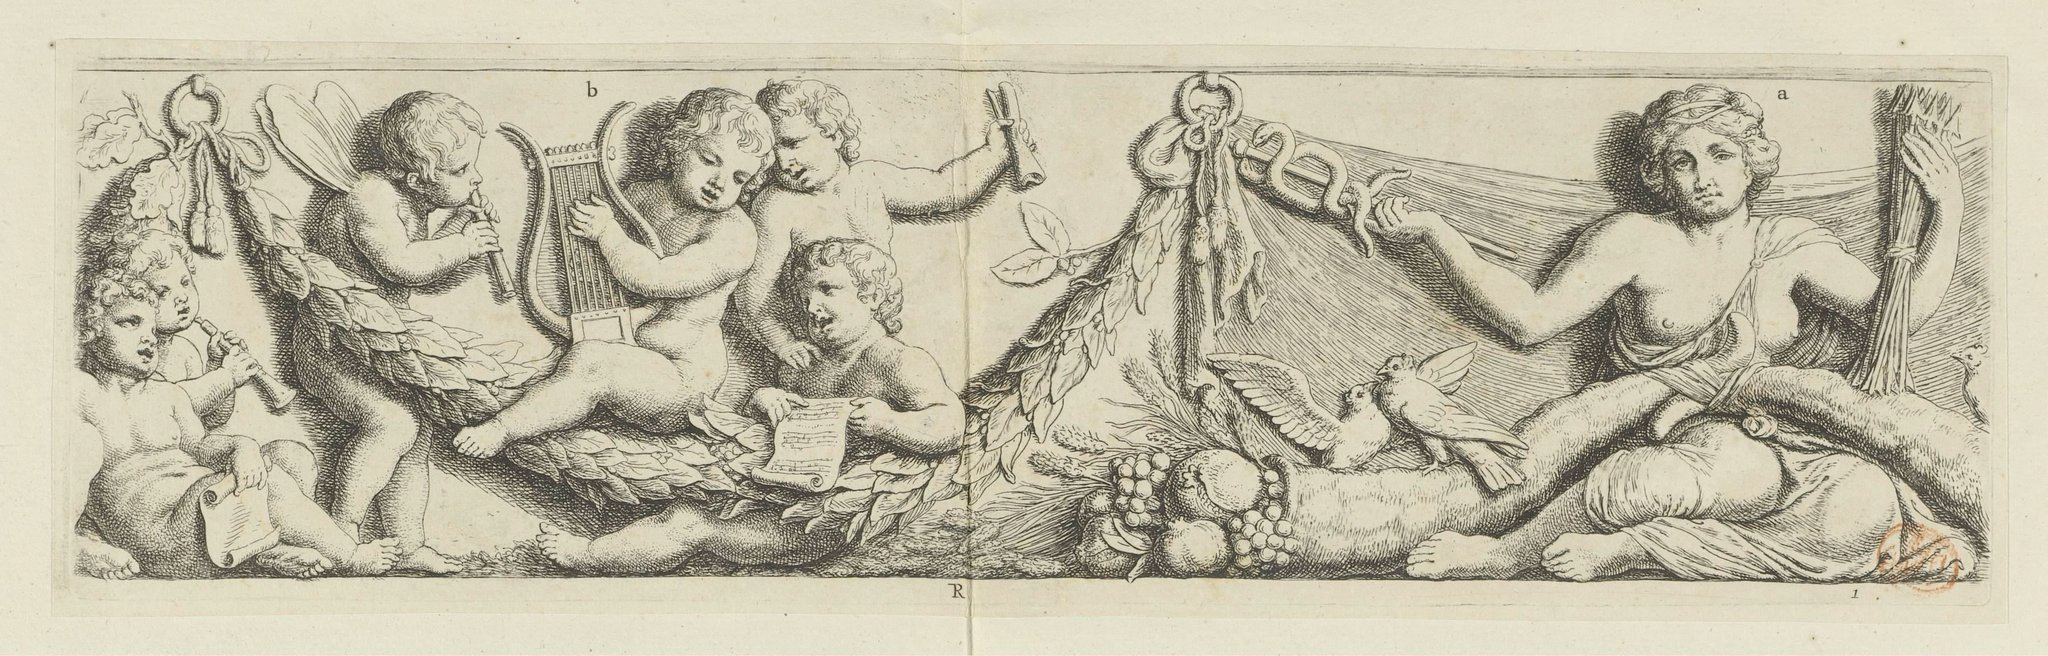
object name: book illustration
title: Deel van fries op schouw in Vroedschapskamer van het Stadhuis op de Dam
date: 1663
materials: paper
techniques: engraving, etching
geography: amsterdam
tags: musical instruments; group of musical instruments, 'cornucopia', horn of plenty, strife between virtues and vices, psychomachy, allegory, personification of good government, cupids: 'amores', 'amoretti', 'putti'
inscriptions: collector's mark: Lugt 195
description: Prent gebruikt in: Secunca pars Praecipuarum effigierum ac ornamentorum amplissime Curiae Amstelrodamensis maiori ex parte in cadido marmore effectorum per Artum Quellinium eiusdem Civitatis Statuarium / Het tweede deel Van de voornaemste Statuen ende Cieraten van 't konst-rijcke Stadt-huys van Amstelredam 'tmeeste in Marmer gemaeckt door Artus Quellinus Beelthouwer der voorseyde Stadt. Amsterdam: Artus Quellinus (I), 1663. Zie RP-P-AO-22-2-1 voor bijhorende titelpagina. Zie RP-P-AO-22-2-2 voor bijhorend register. Zie RP-P-AO-22-2A, RP-P-AO-22-2B, RP-P-AO-22-2C-1, RP-P-AO-22-2C-2, RP-P-AO-22-2C-3, RP-P-AO-22-2C-4, RP-P-AO-22-2D-1, RP-P-AO-22-2D-2, RP-P-AO-22-2D-3, RP-P-AO-22-2E-1, RP-P-AO-22-2E-2, RP-P-AO-22-2E-3, RP-P-AO-22-2E-4, RP-P-AO-22-2F-1, RP-P-AO-22-2F-2, RP-P-AO-22-2F-3, RP-P-AO-22-2G, RP-P-AO-22-2H, RP-P-AO-22-2I, RP-P-AO-22-2K, RP-P-AO-22-2L, RP-P-AO-22-2M, RP-P-AO-22-2N, RP-P-AO-22-2O-1, RP-P-AO-22-2O-2, RP-P-AO-22-2O-3, RP-P-AO-22-2O-4, RP-P-AO-22-2O-5, RP-P-AO-22-2O-6, RP-P-AO-22-2O-7, RP-P-AO-22-2P-1, RP-P-AO-22-2P-2, RP-P-AO-22-2Q-1, RP-P-AO-22-2Q-2, RP-P-AO-22-2Q-3, RP-P-AO-22-2R-2, RP-P-AO-22-2R-3, RP-P-AO-22-2S, RP-P-AO-22-2T-1, RP-P-AO-22-2T-2, RP-P-AO-22-2T-3, RP-P-AO-22-2T-4, RP-P-AO-22-2V-1, RP-P-AO-22-2V-2, RP-P-AO-22-2W-1, RP-P-AO-22-2W-2, RP-P-AO-22-2X-1, RP-P-AO-22-2X-2 en RP-P-AO-22-2X-3 voor andere prenten uit deze publicatie. Zelfde staat van prent ook gebruikt in: Secunca pars Praecipuarum effigierum ac ornamentorum amplissime Curiae Amstelrodamensis maiori ex parte in cadido marmore effectorum per Artum Quellinium eiusdem Civitatis Statuarium / Het tweede deel Van de voornaemste Statuen ende Cieraten van 't konst-rijcke Stadt-huys van Amstelredam 'tmeeste in Marmer gemaeckt door Artus Quellinus Beelthouwer der voorseyde Stadt. Amsterdam: Frederik de Wit, 1668. Latere staat van prent ook gebruikt in: Architecture peinture et sculpture de la Maison de Ville d'Amsterdam, representee en CIX. figures en taille-douce (…). Amsterdam: David Mortier, 1719. En in: Architecture peinture et sculpture de la Maison de Ville d'Amsterdam, representee en CIX. figures en taille-douce (…). Amsterdam: Gerard Valck, 1719. En in: Bouw schilder en beeldhouwkonst, van het Stadhuis te Amsteldam, vertoont in CIX figuuren (…). Amsterdam: Covens & Mortier & Covens Jr., s.a. (1774-1783).